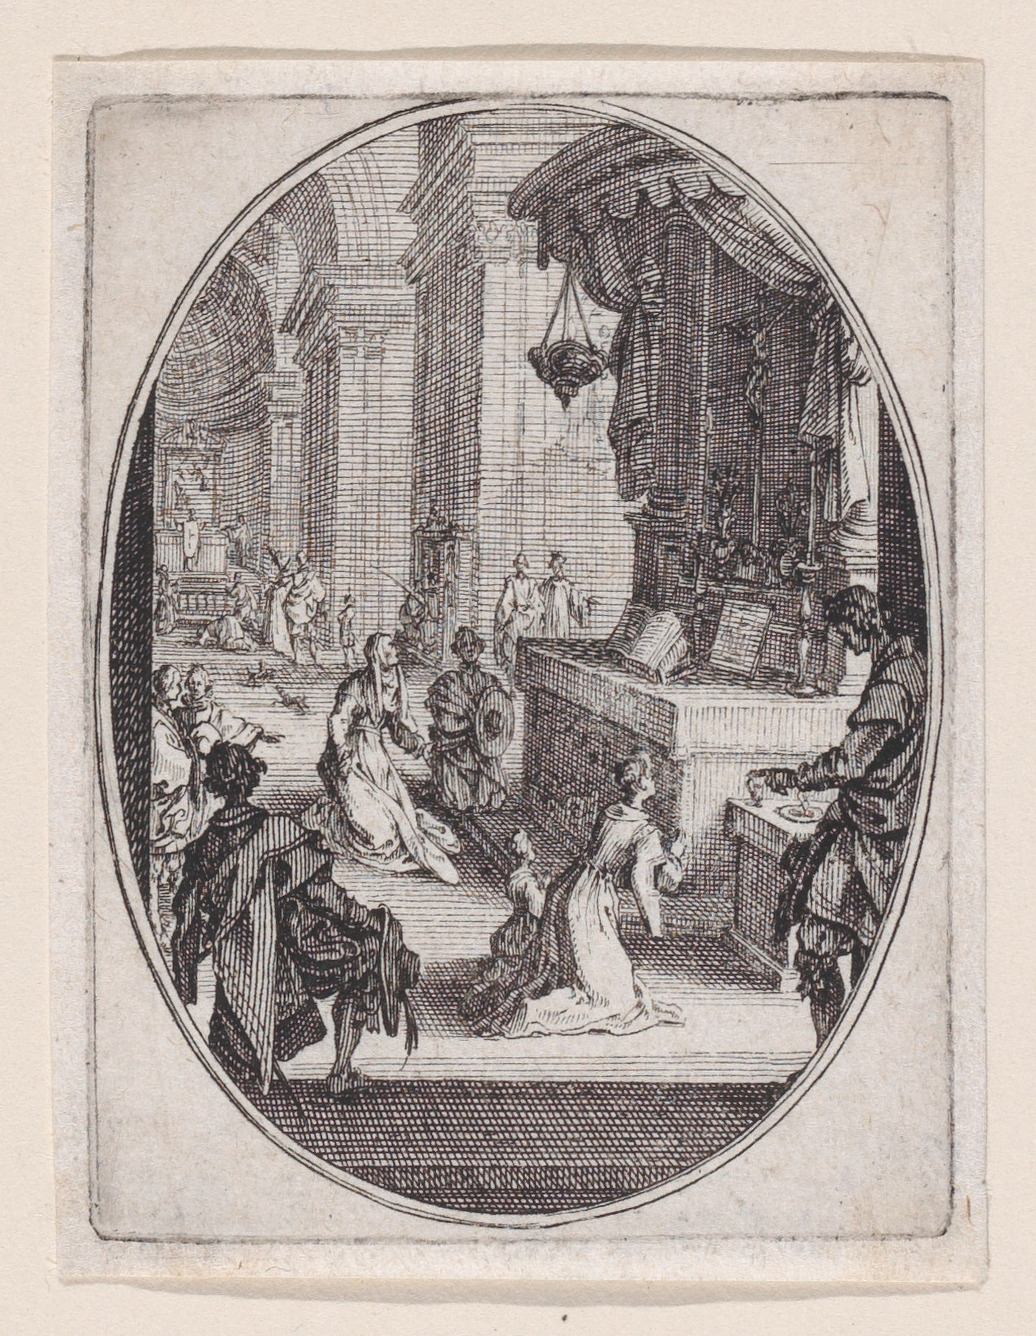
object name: print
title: Le Culte de Dieu (The Worship of God), from "Les Sacrifices" (The Sacrifices)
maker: jacques callot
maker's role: artist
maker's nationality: french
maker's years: 1592-1635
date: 1625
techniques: etching